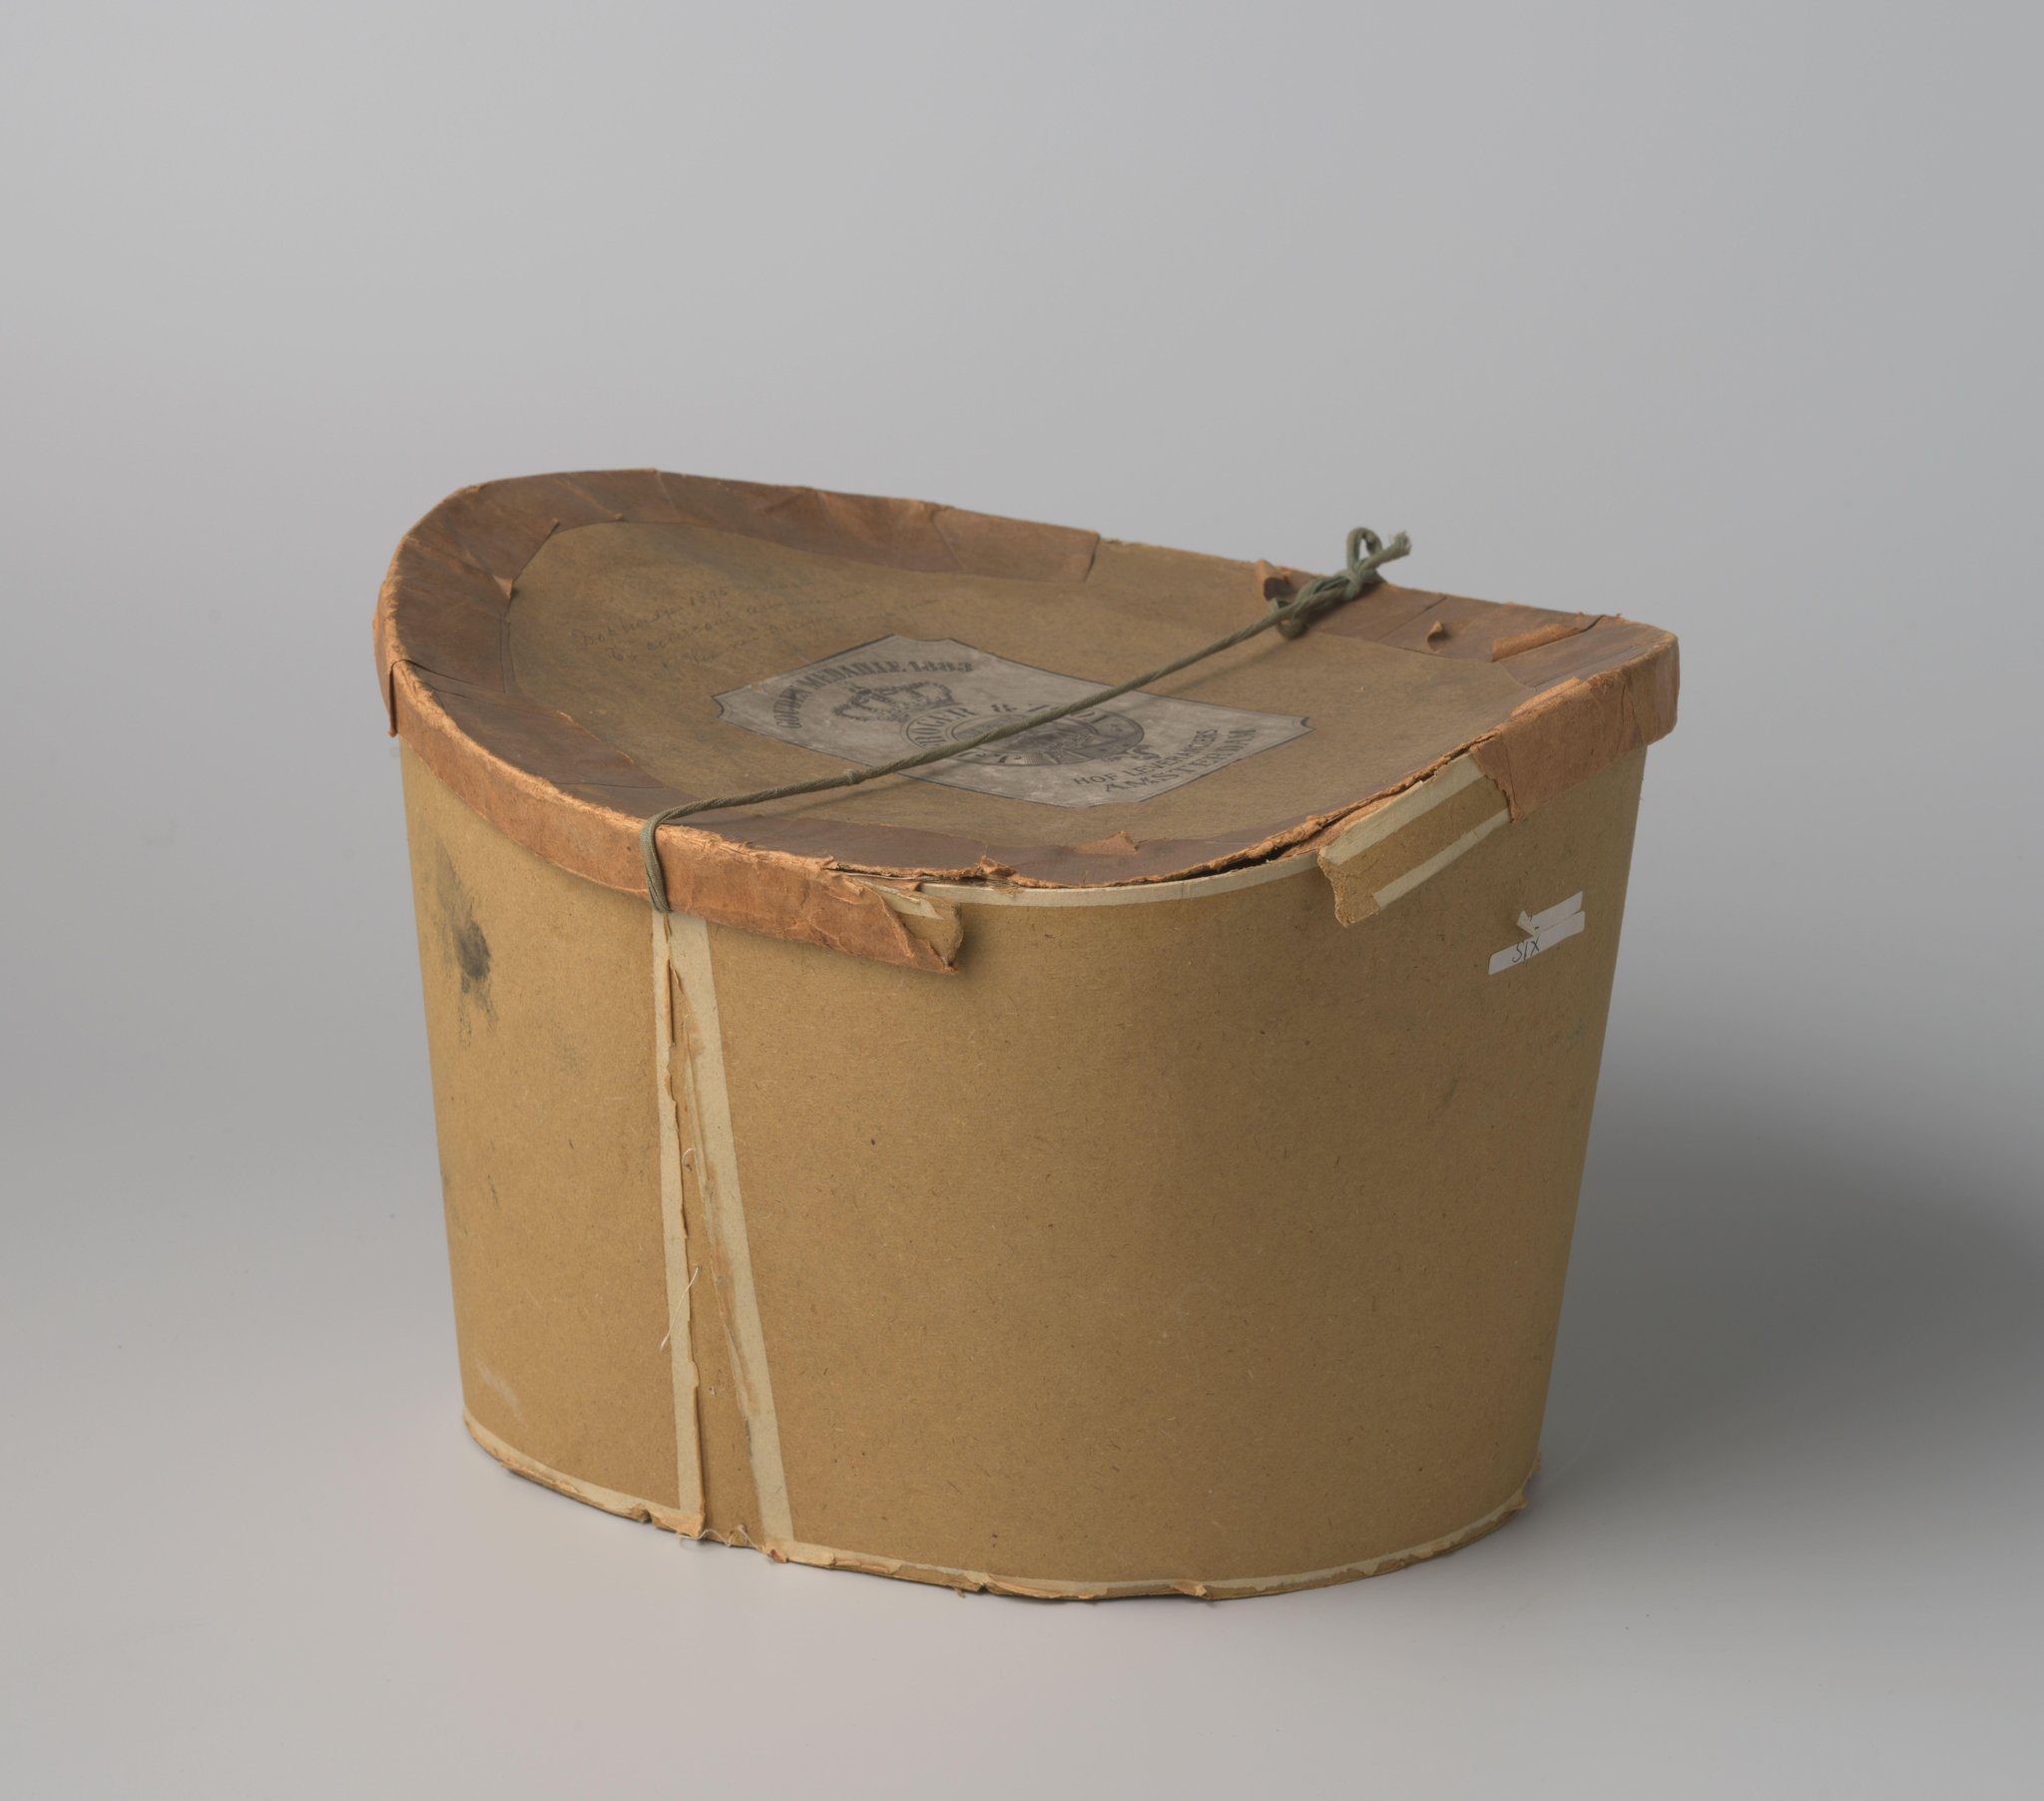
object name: hat box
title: Ovale hoedendoos van karton; op het deksel een etiket van Froger & Zoon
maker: isaäc johannes froger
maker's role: hoedenmaker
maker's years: 1781-1843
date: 1895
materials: cardboard, linen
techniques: pasting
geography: amsterdam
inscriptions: company name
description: Ovale hoedendoos van karton; op het deksel een etiket van Froger & Zoon. De bodem ontbreekt.